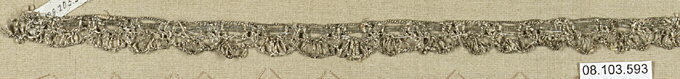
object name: piece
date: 1701-1900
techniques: lace